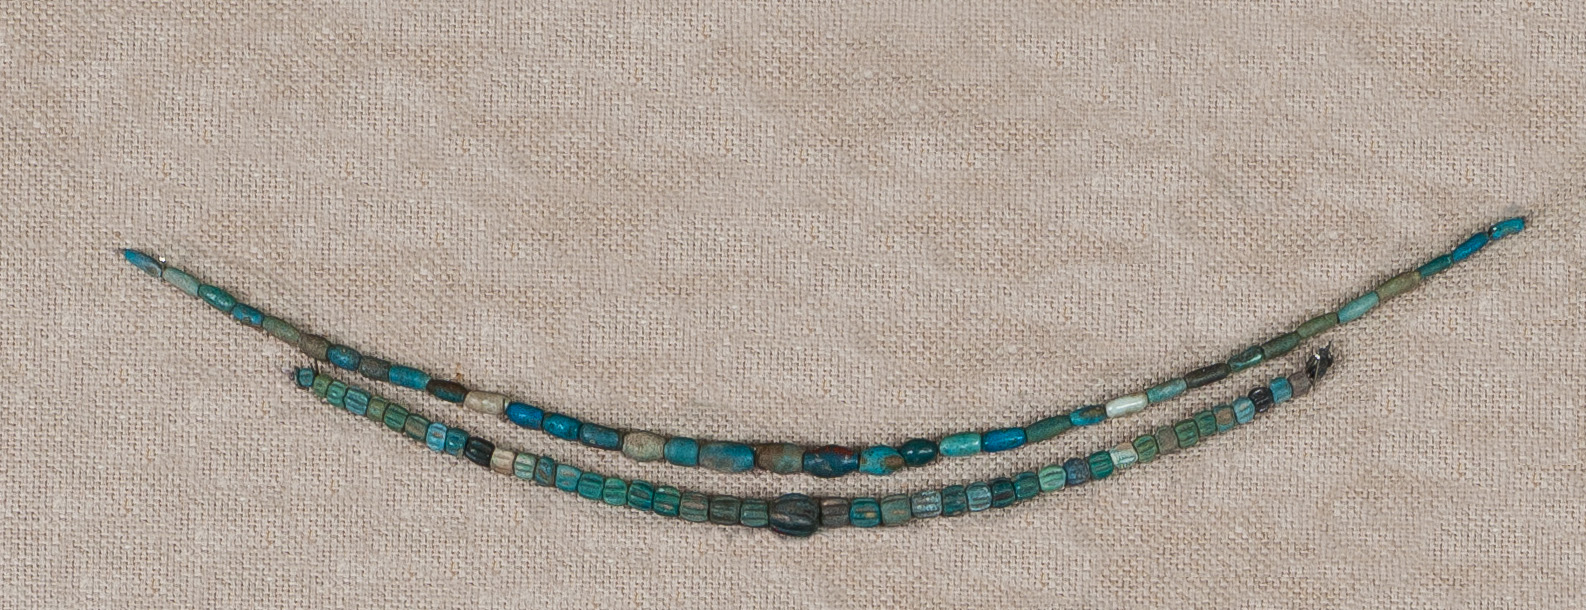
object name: necklace, bead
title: Necklace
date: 1981-1295 BCE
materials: faience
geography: egypt